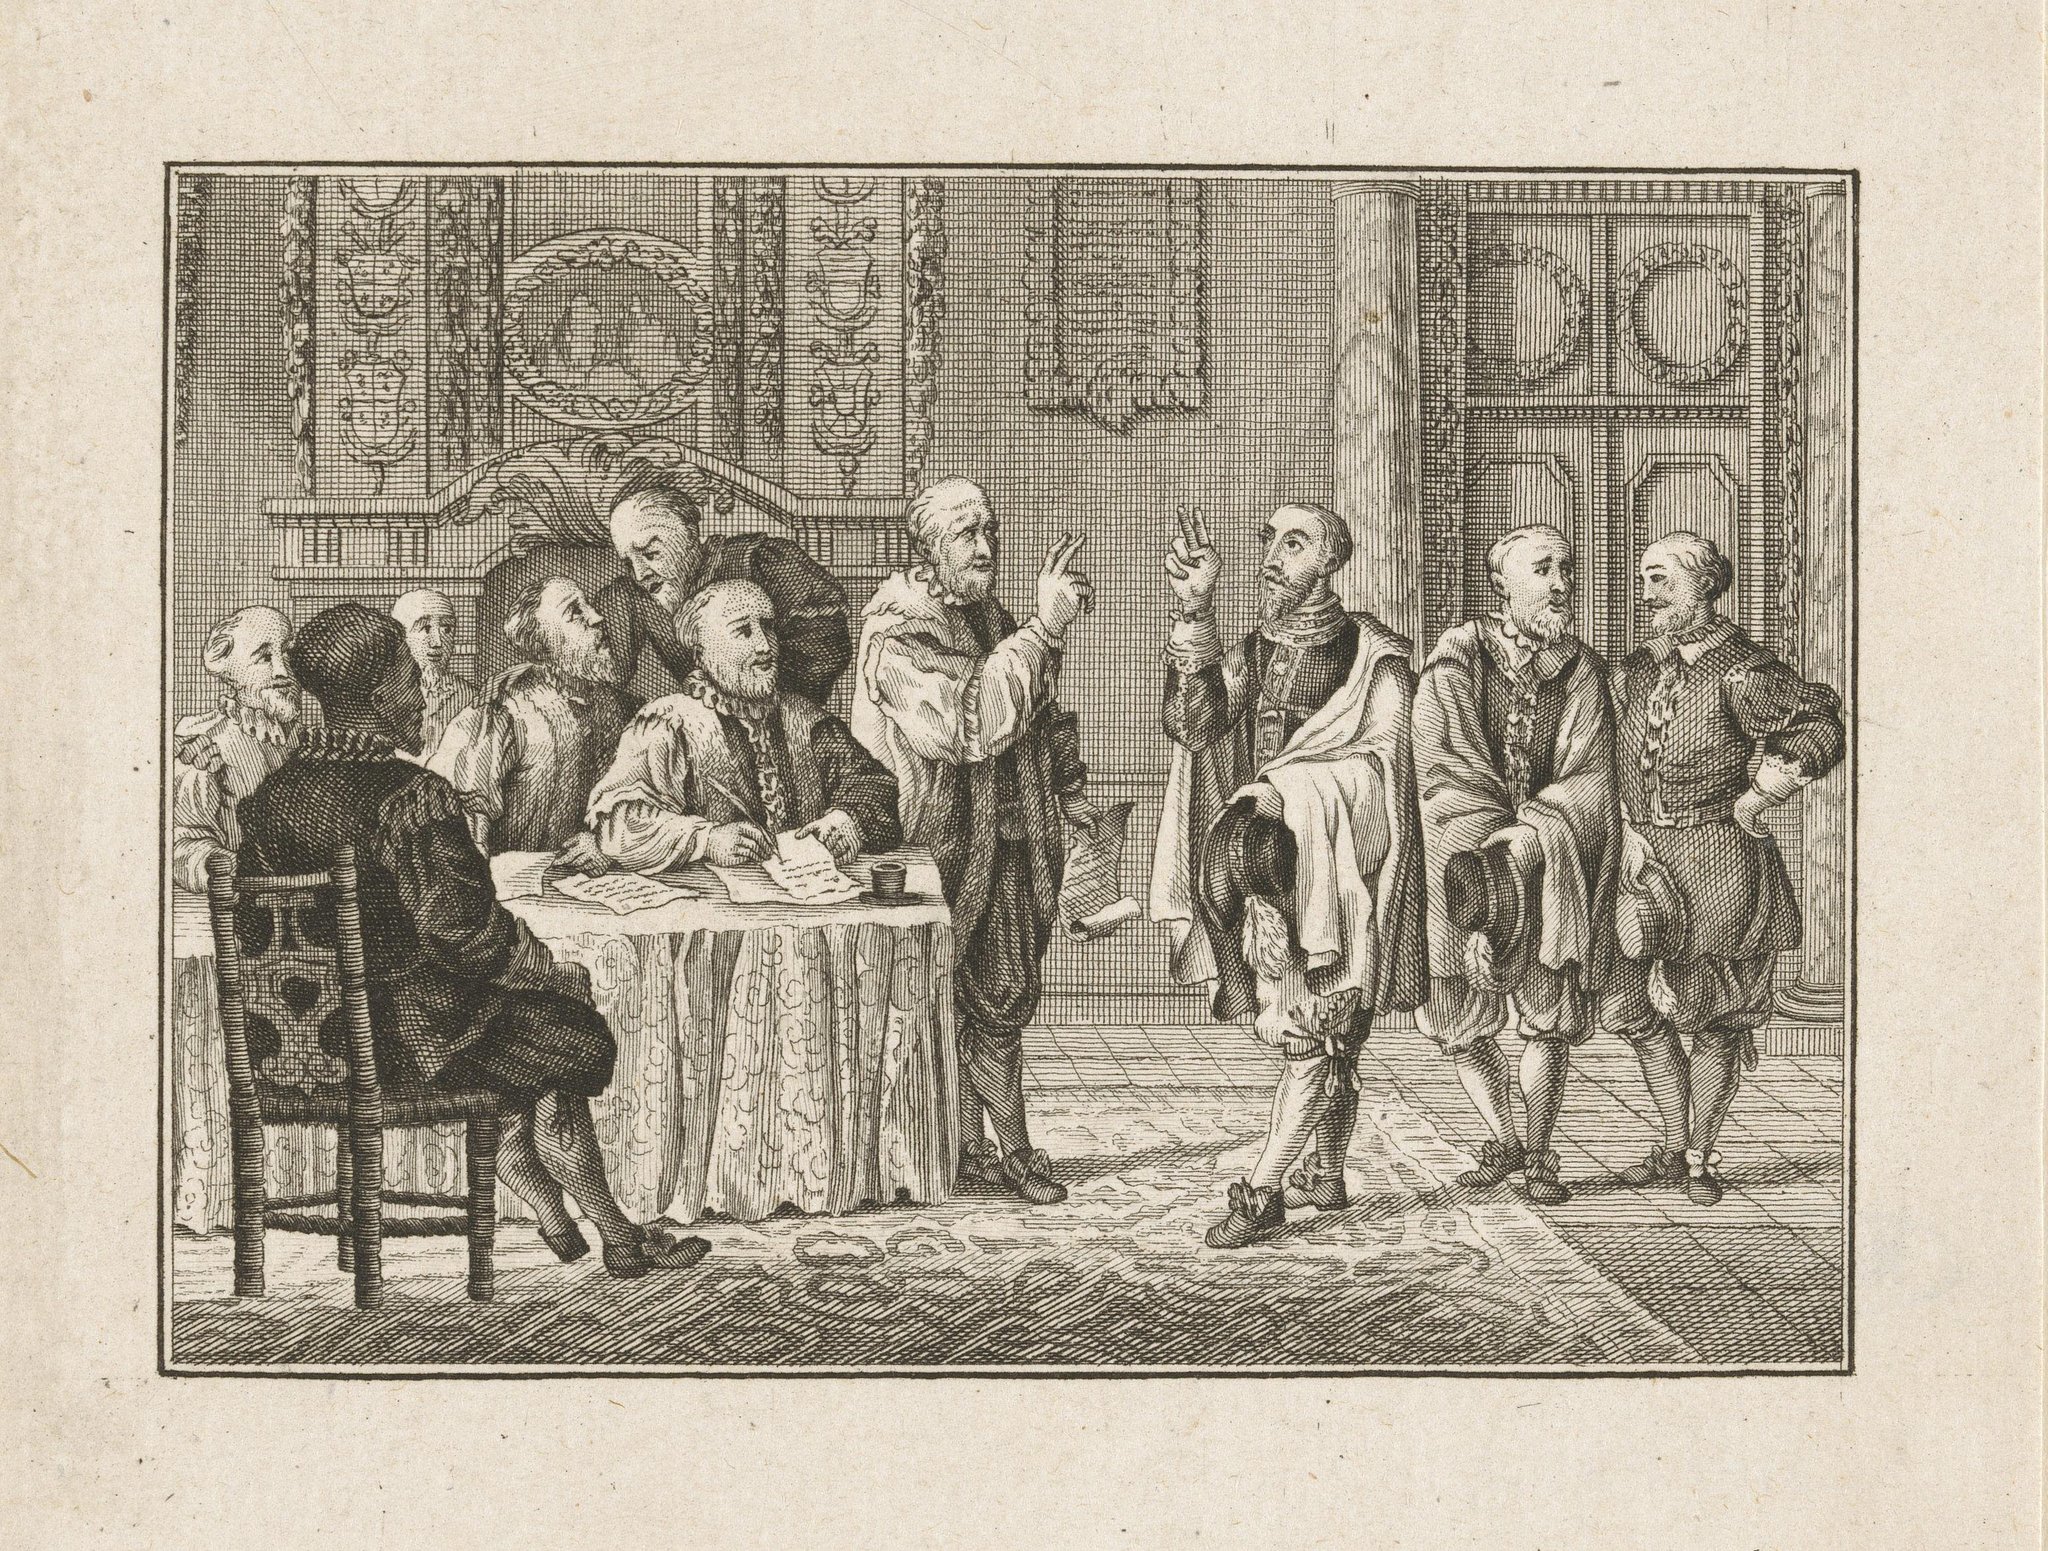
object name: history print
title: Burgemeester Joost Buyck van Amsterdam neemt Filips II de eed af, 1549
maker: barent de bakker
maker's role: print maker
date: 1780-1782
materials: paper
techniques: etching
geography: northern netherlands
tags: philip ii of spain, leiden, swearing an oath (with two fingers raised), amsterdam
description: Burgemeester Joost Buyck van Amsterdam neemt Filips II de eed als graaf van Holland af, 1549. Interieur met de koning staande voor een tafel waarachter de burgemeester is gezeten.